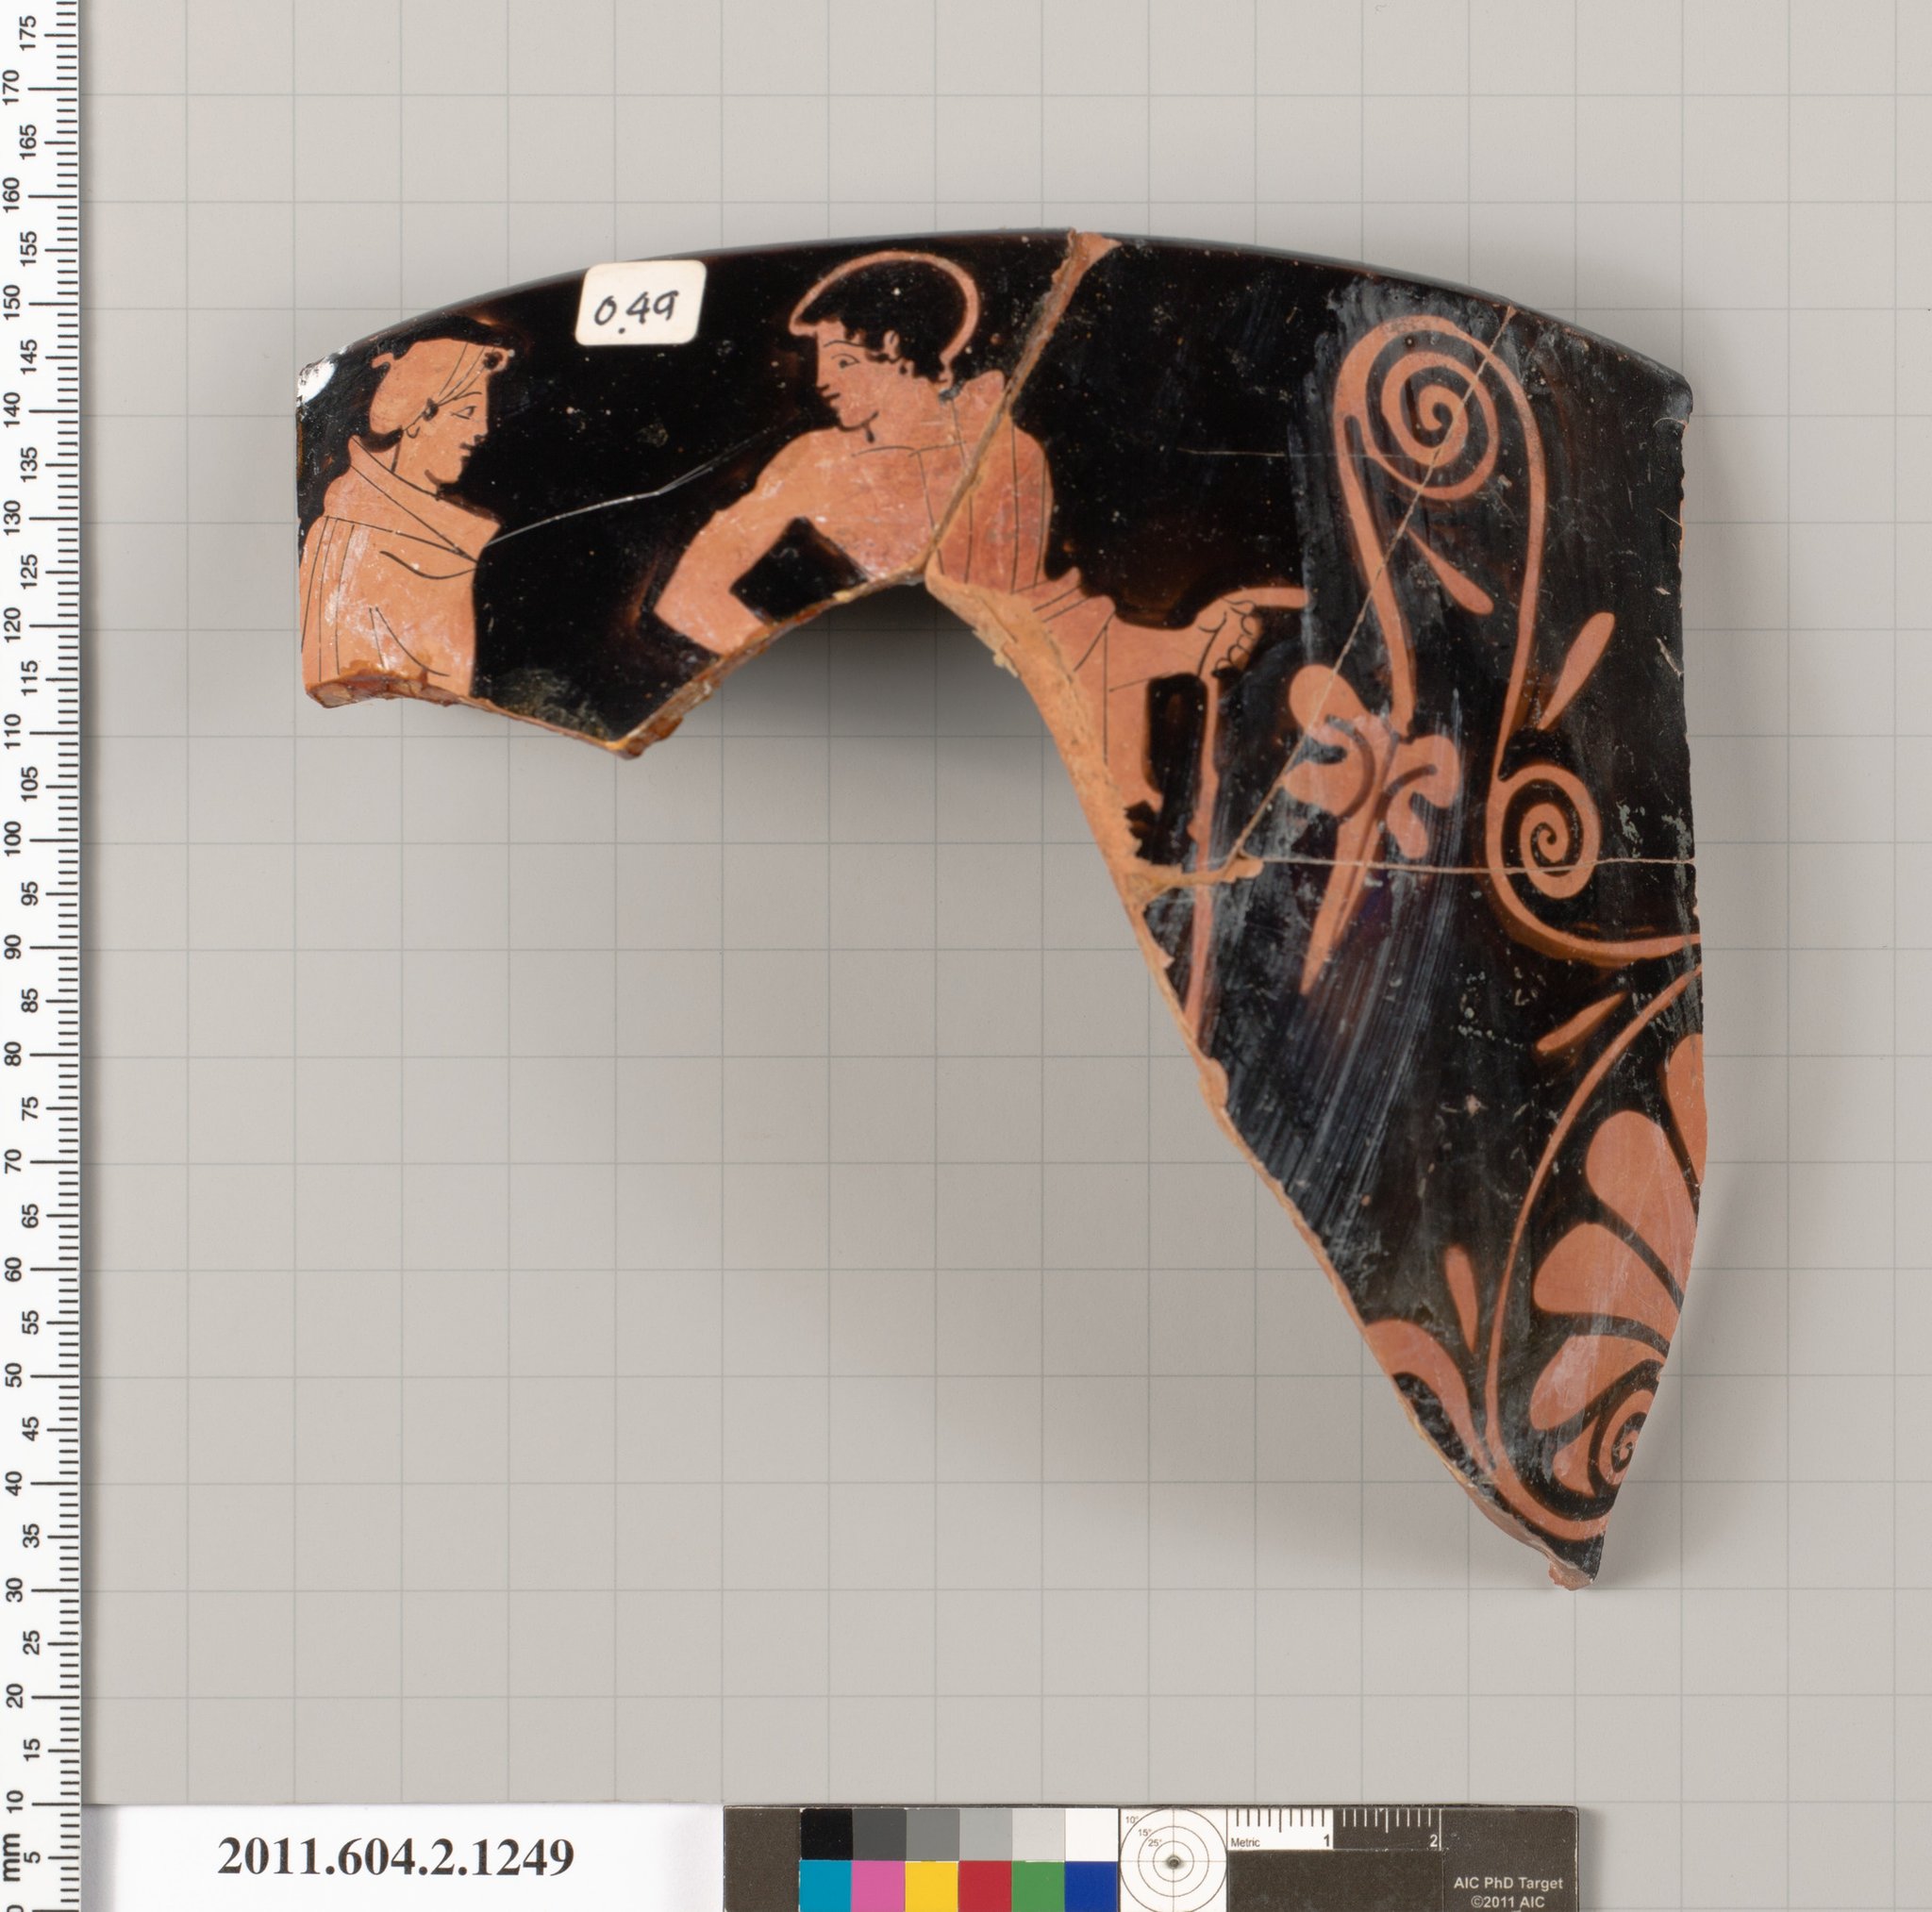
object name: skyphos fragment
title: Terracotta fragment of a skyphos (deep drinking cup)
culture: greek, attic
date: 467-435 BCE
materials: terracotta